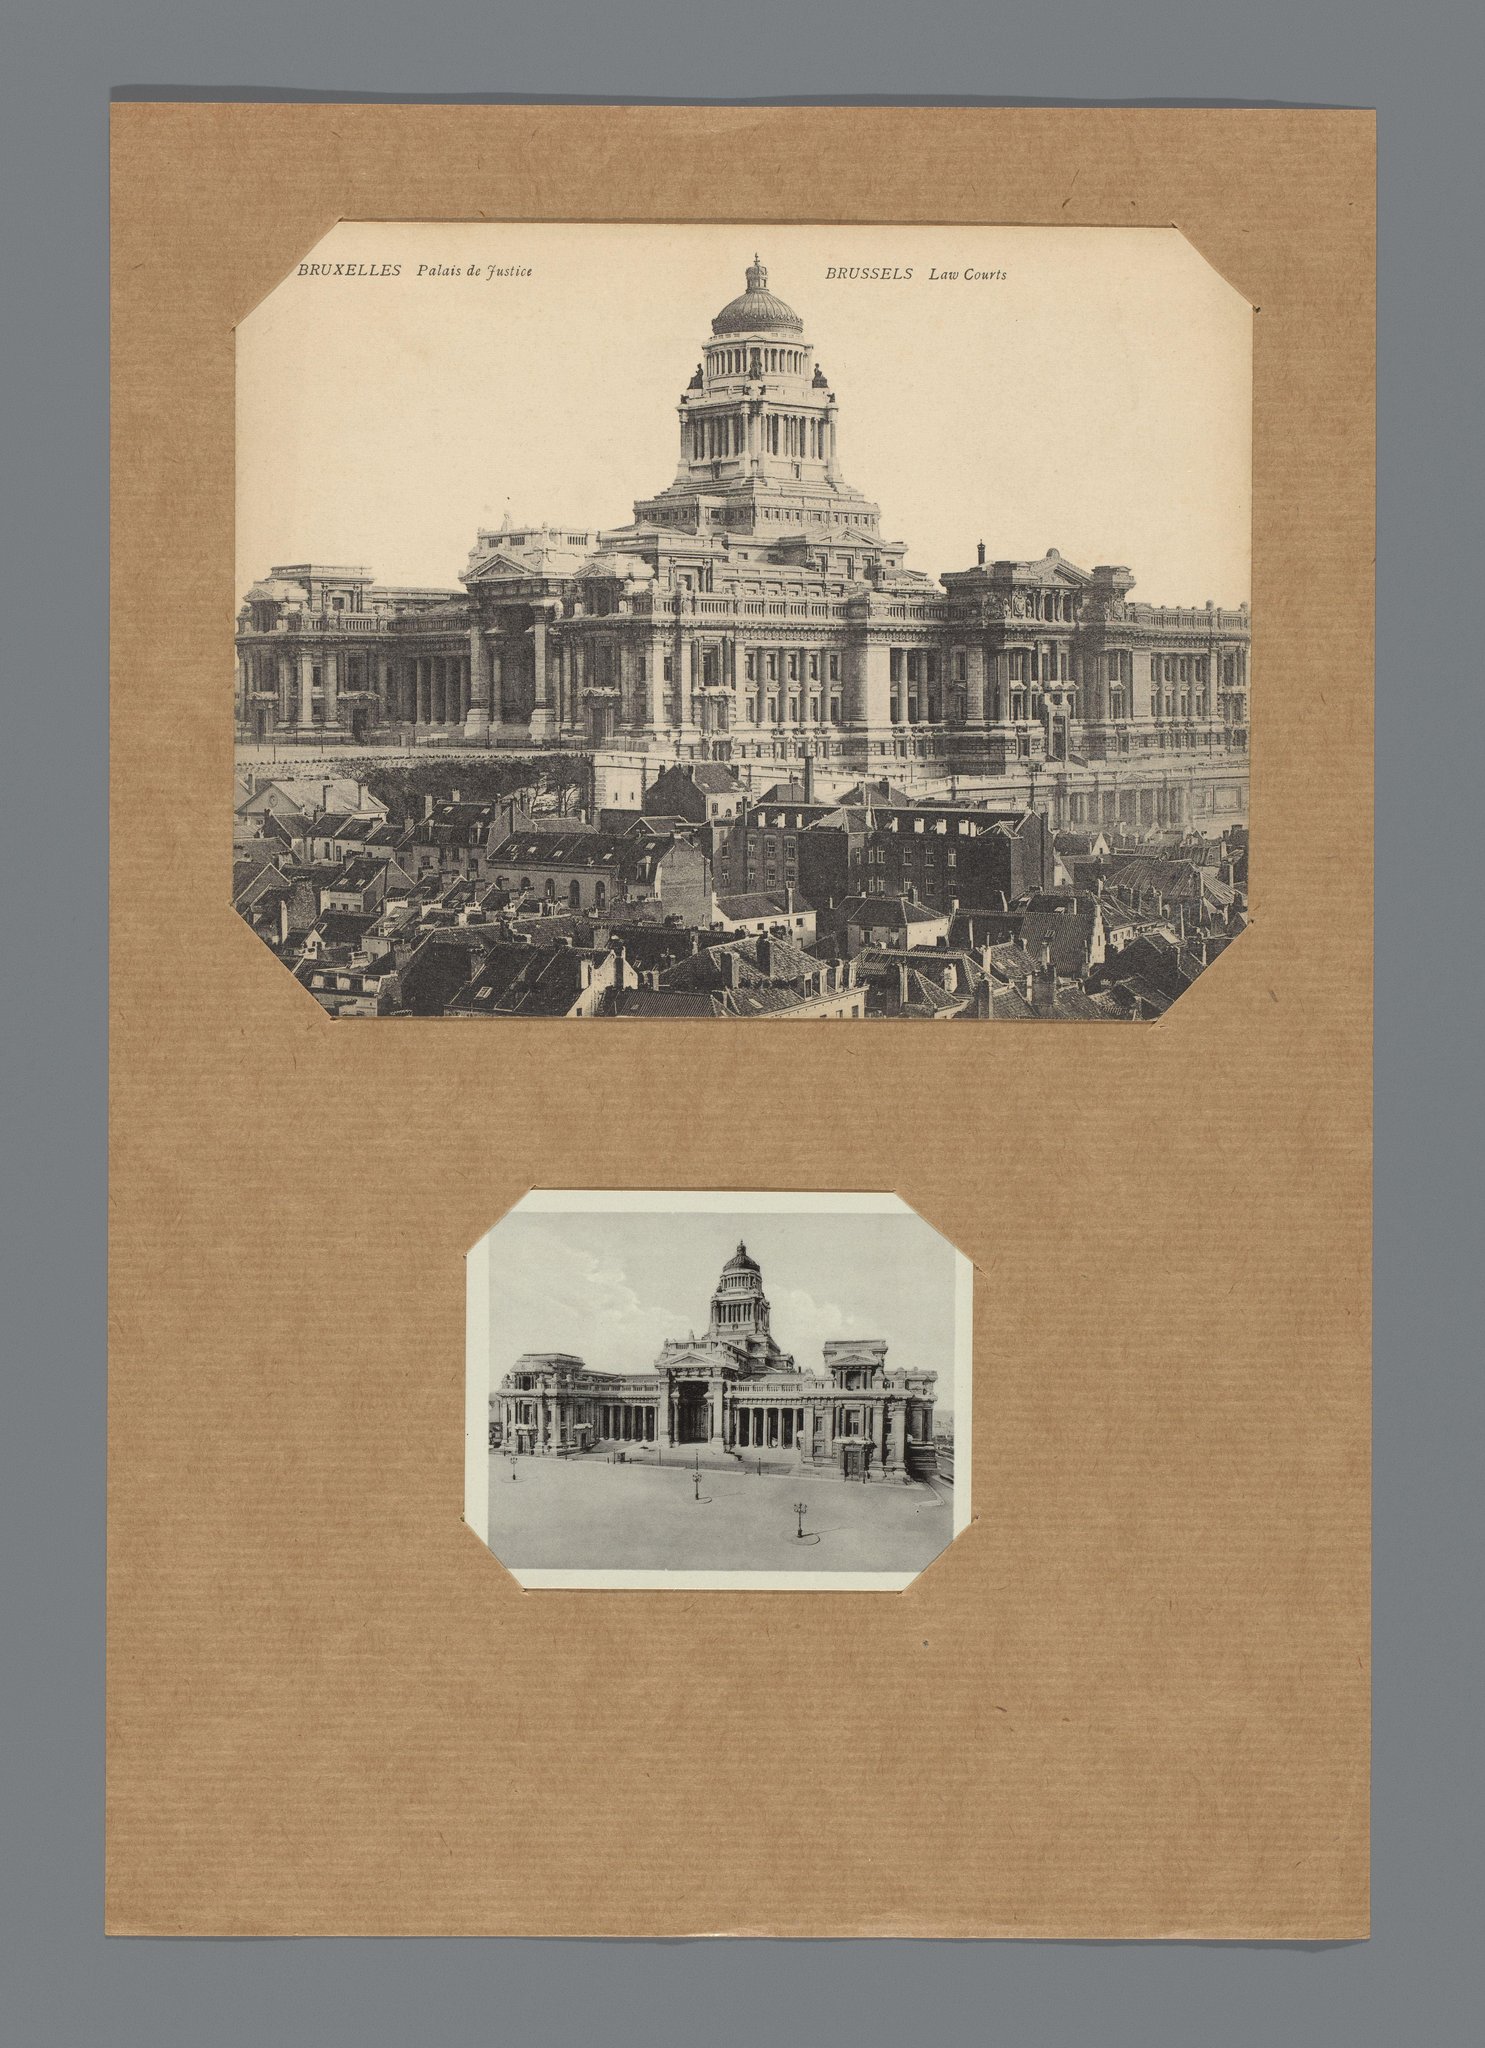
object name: photograph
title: Brussels. Palais de Justice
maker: Anonymous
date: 1860-1925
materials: photographic support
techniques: photograph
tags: paleis van justitie